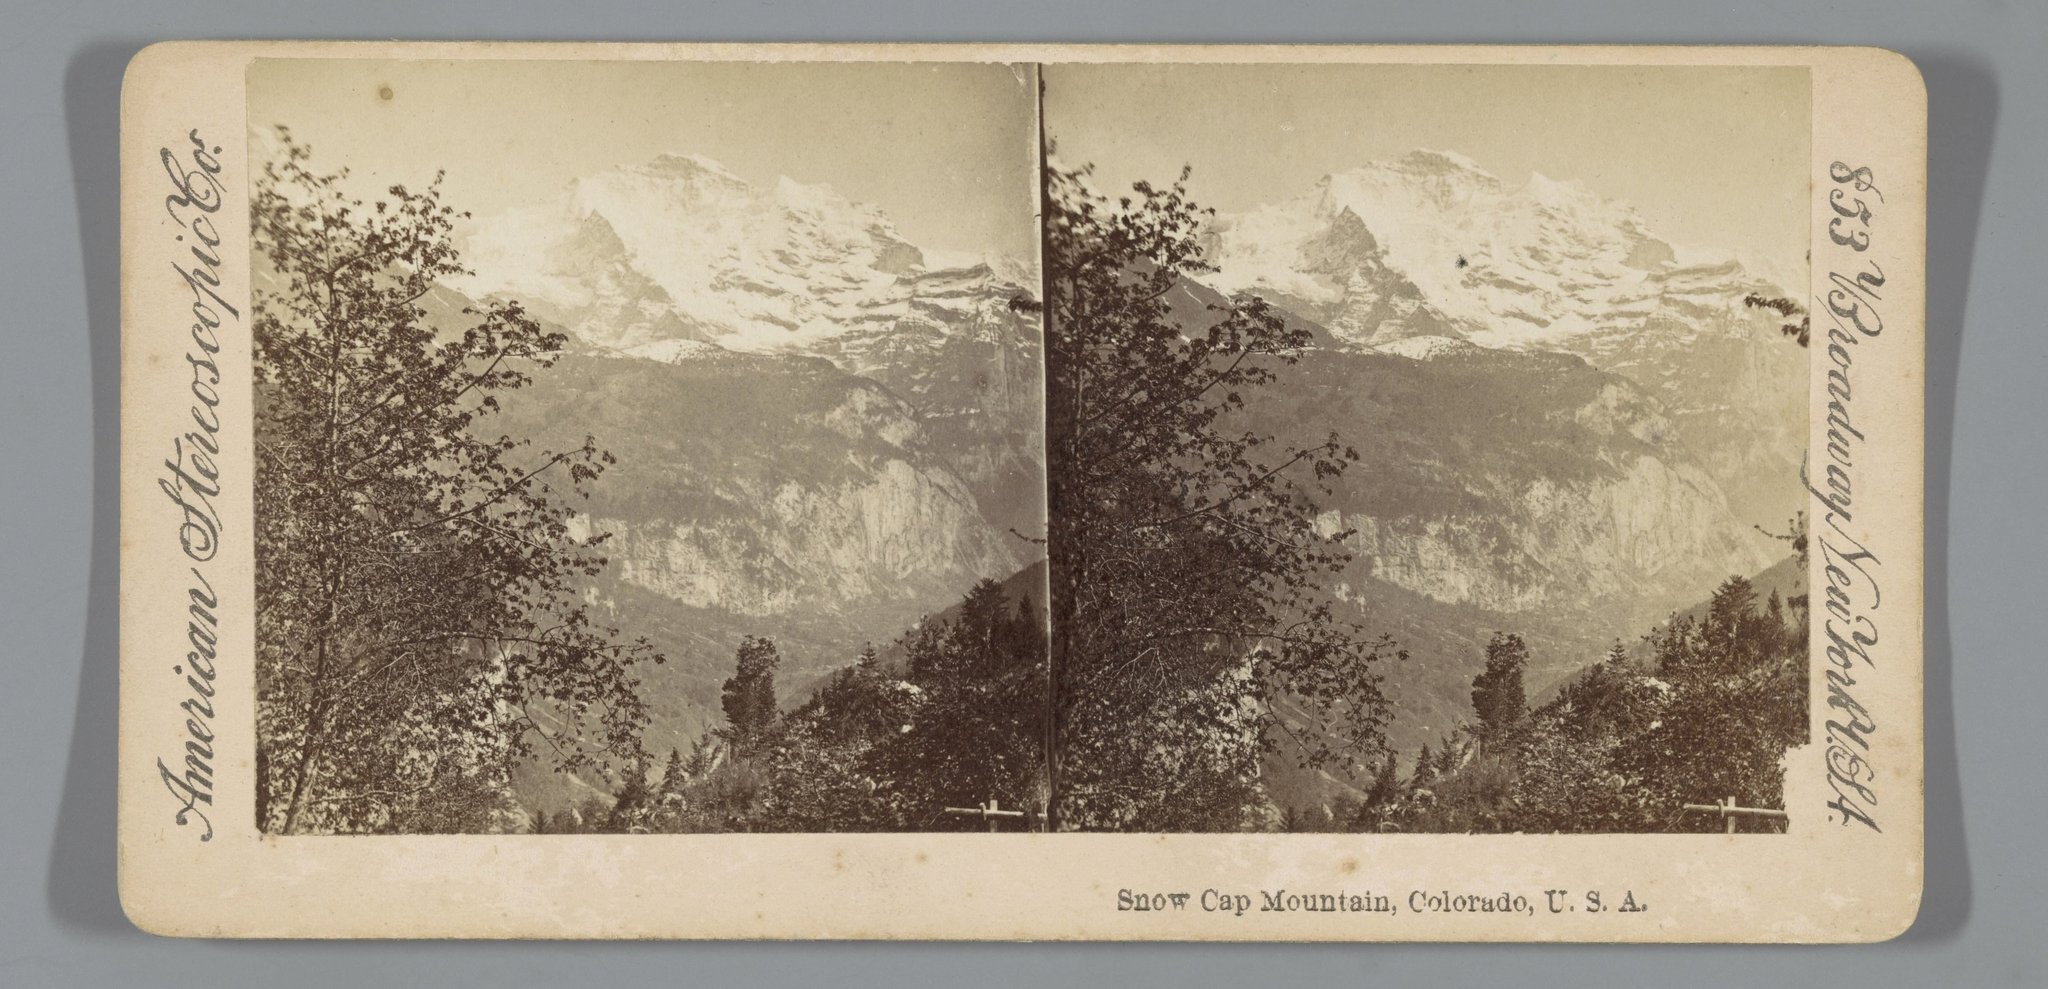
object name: stereograph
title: Snow Cap Mountain, Colorado, U.S.A.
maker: Anonymous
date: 1879-1910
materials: cardboard, paper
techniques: albumen print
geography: colorado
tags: mountain-range, snow peaks